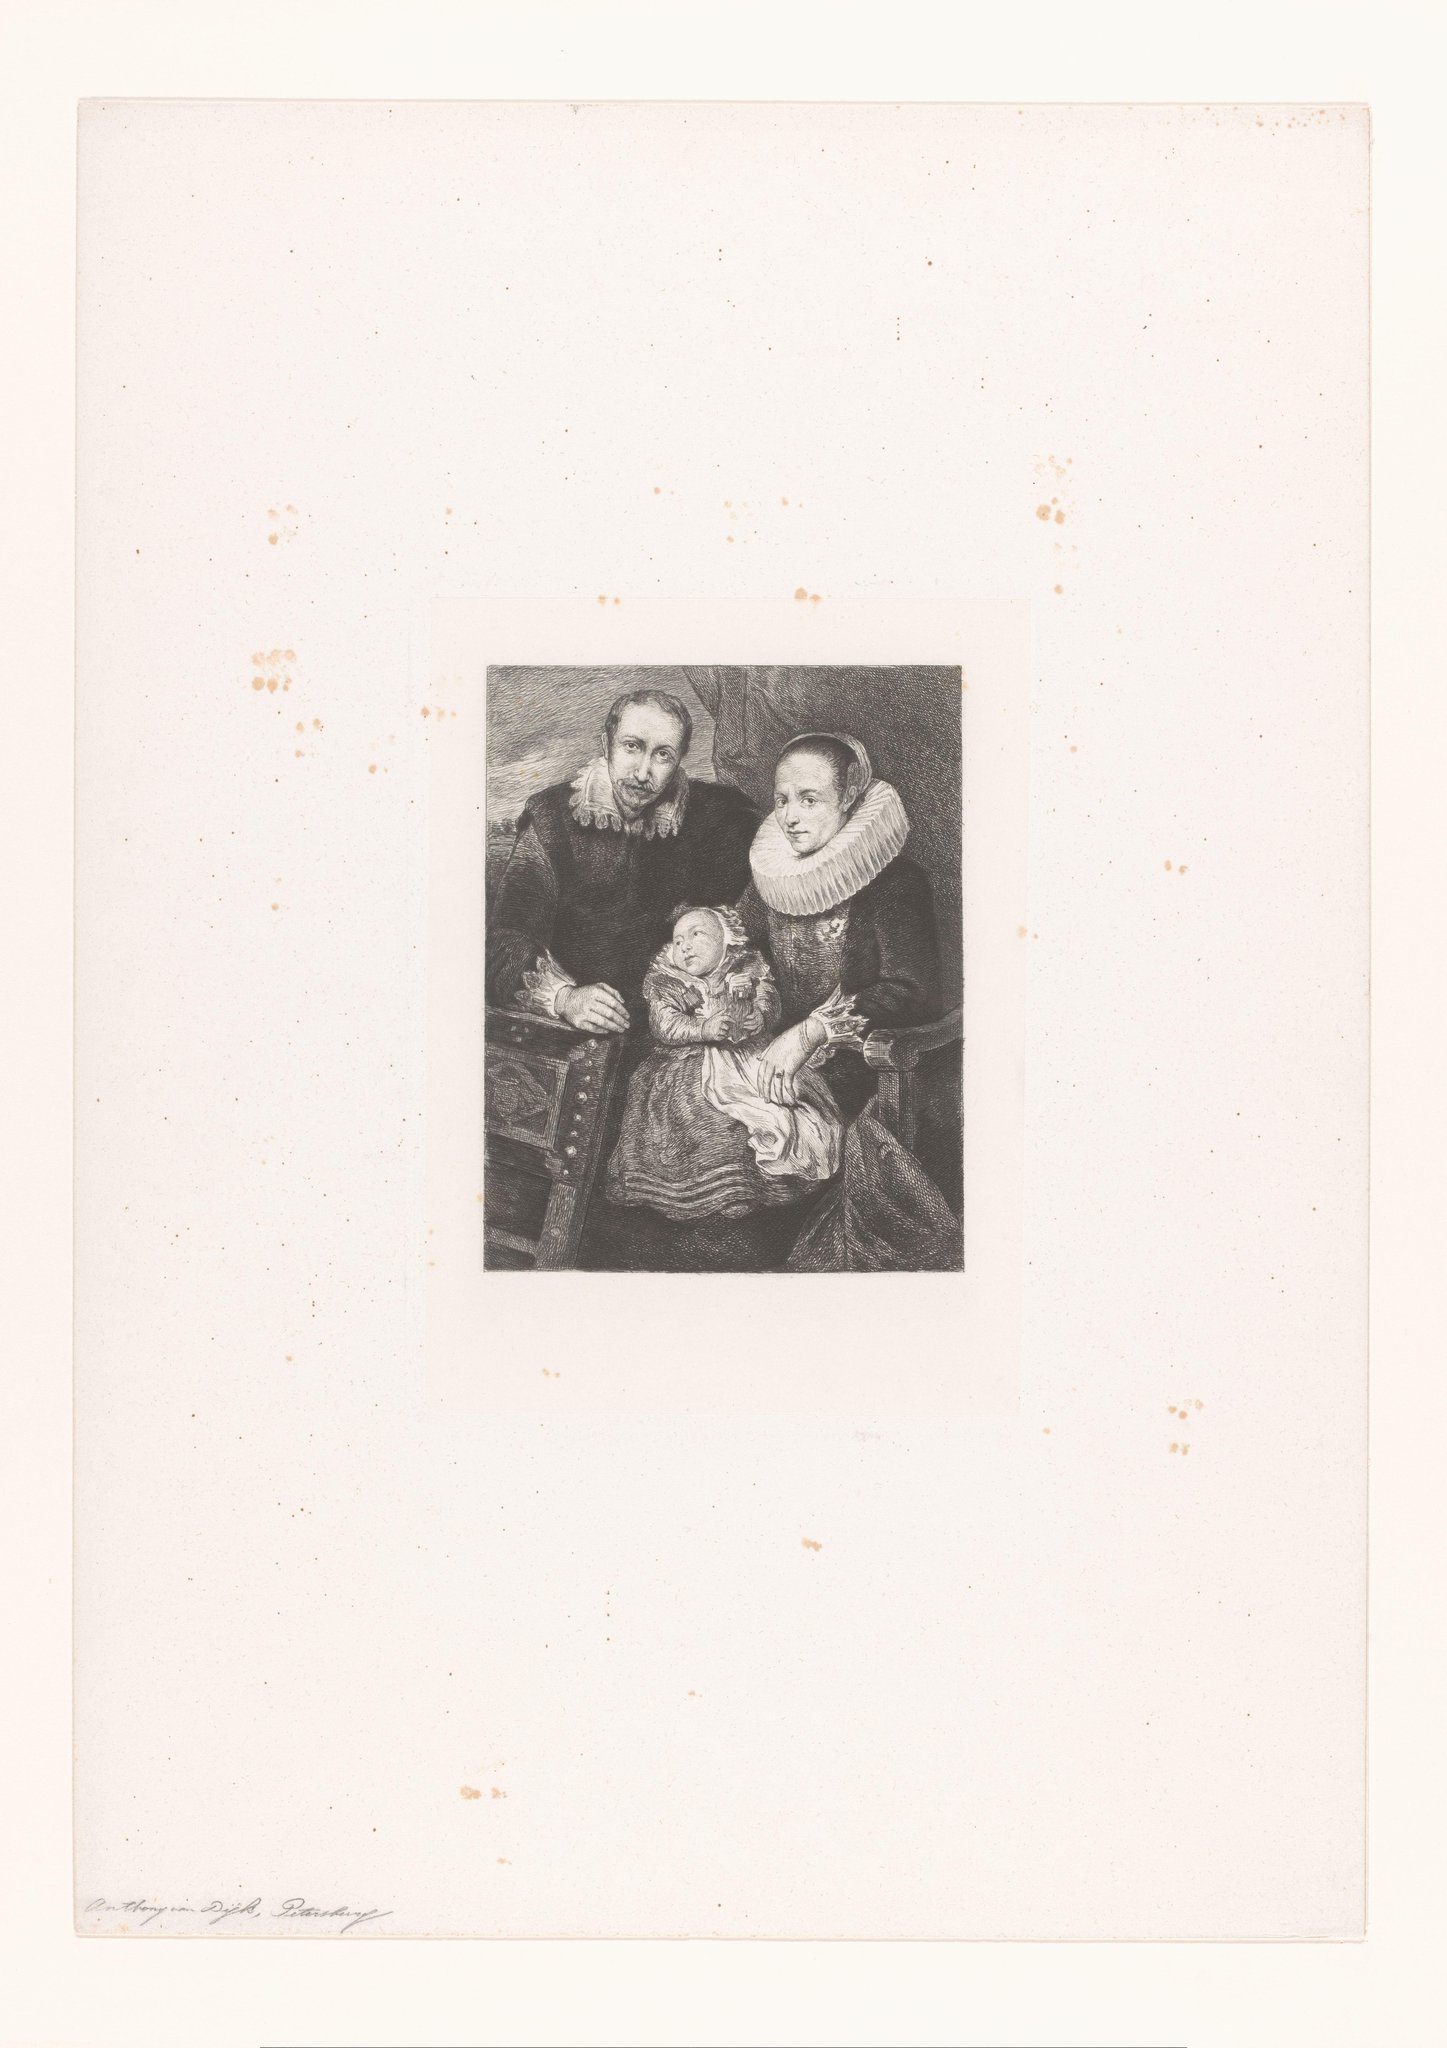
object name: print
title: Portret van een onbekende familie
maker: nikolay semyonovich mosolov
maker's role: print maker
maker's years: 1847-1914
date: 1857-1914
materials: paper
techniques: drypoint, etching, intaglio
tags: family group, especially parents with their child(ren)